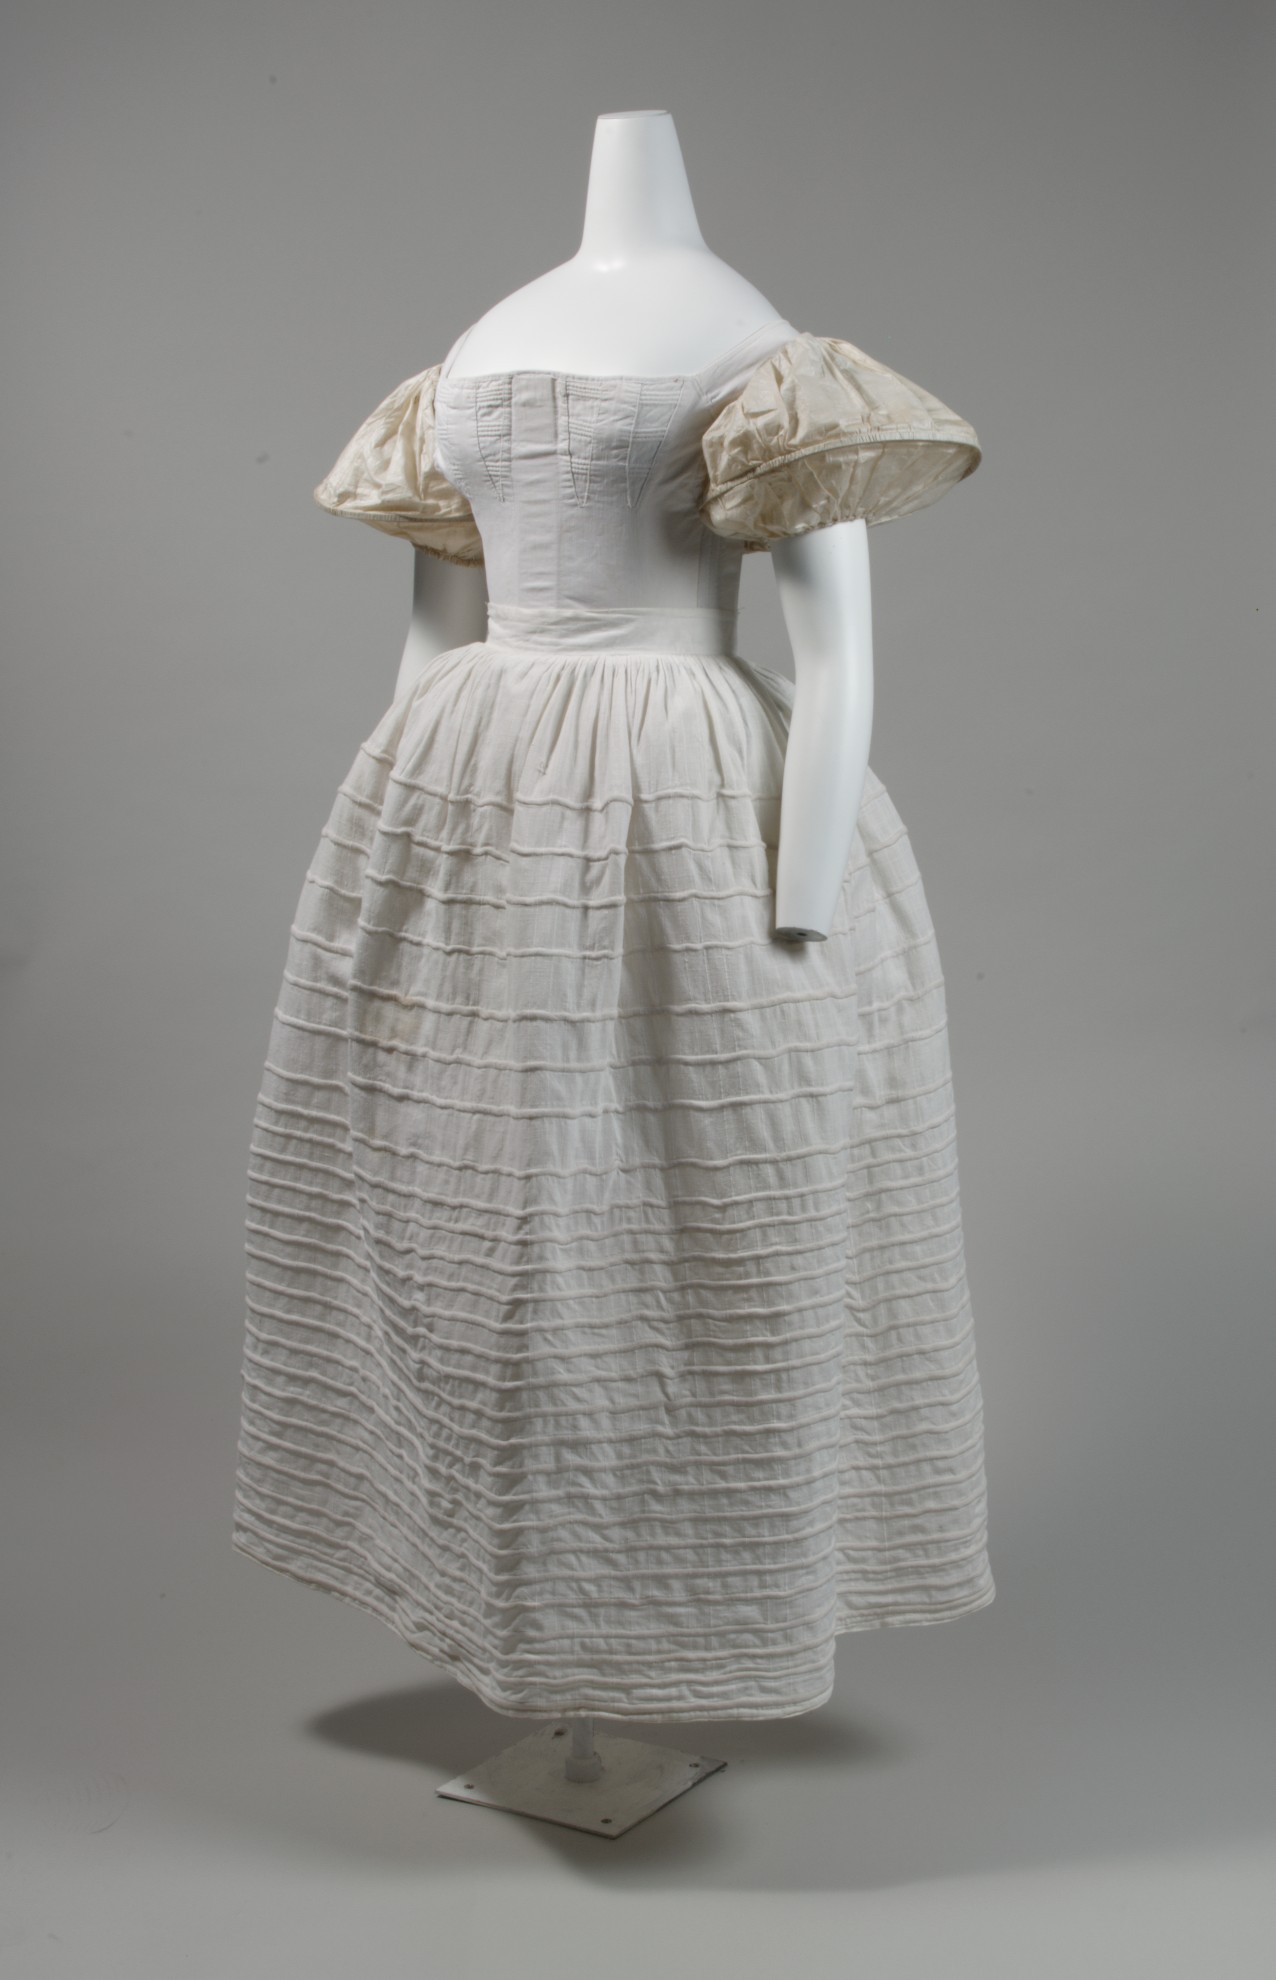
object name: petticoat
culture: american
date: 1830-1839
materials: cotton